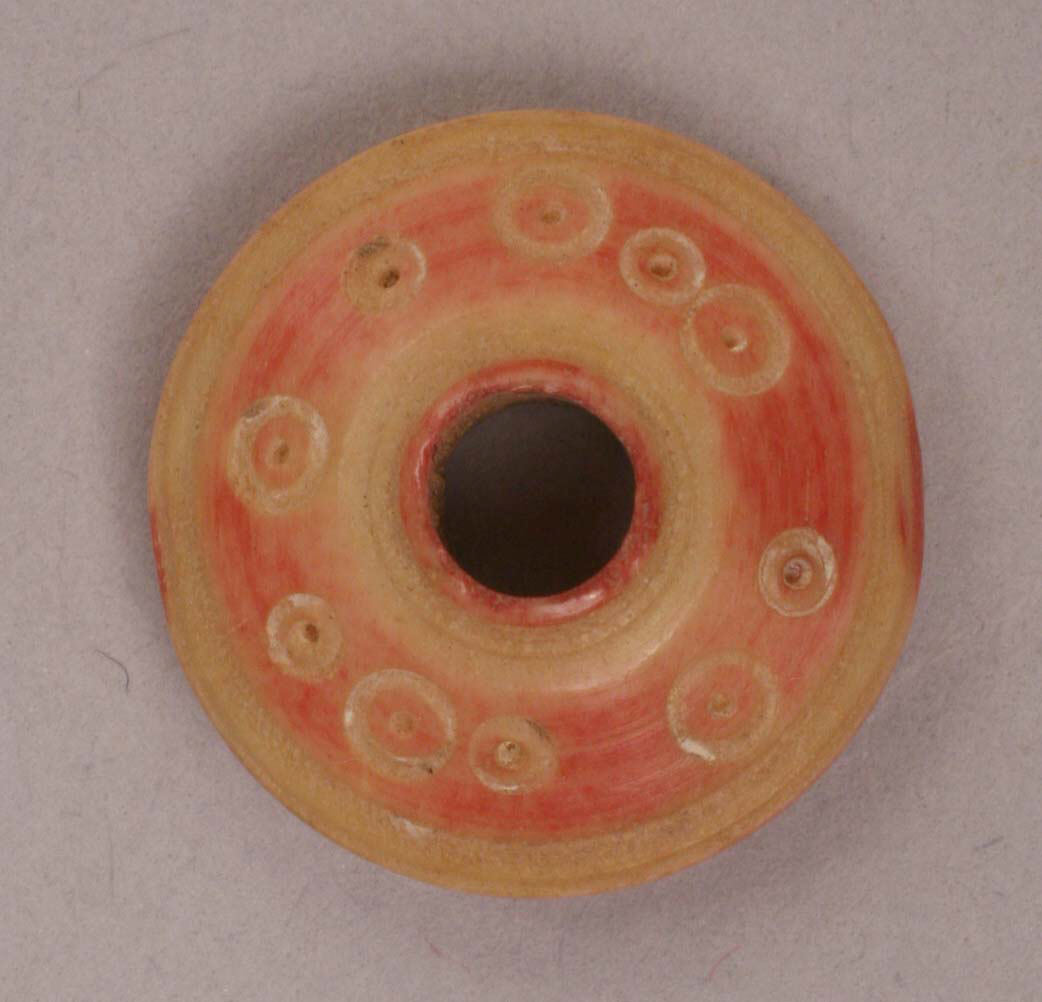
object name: button or bead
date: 801-1000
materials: bone, paint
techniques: incising, inlay, tinting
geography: iran